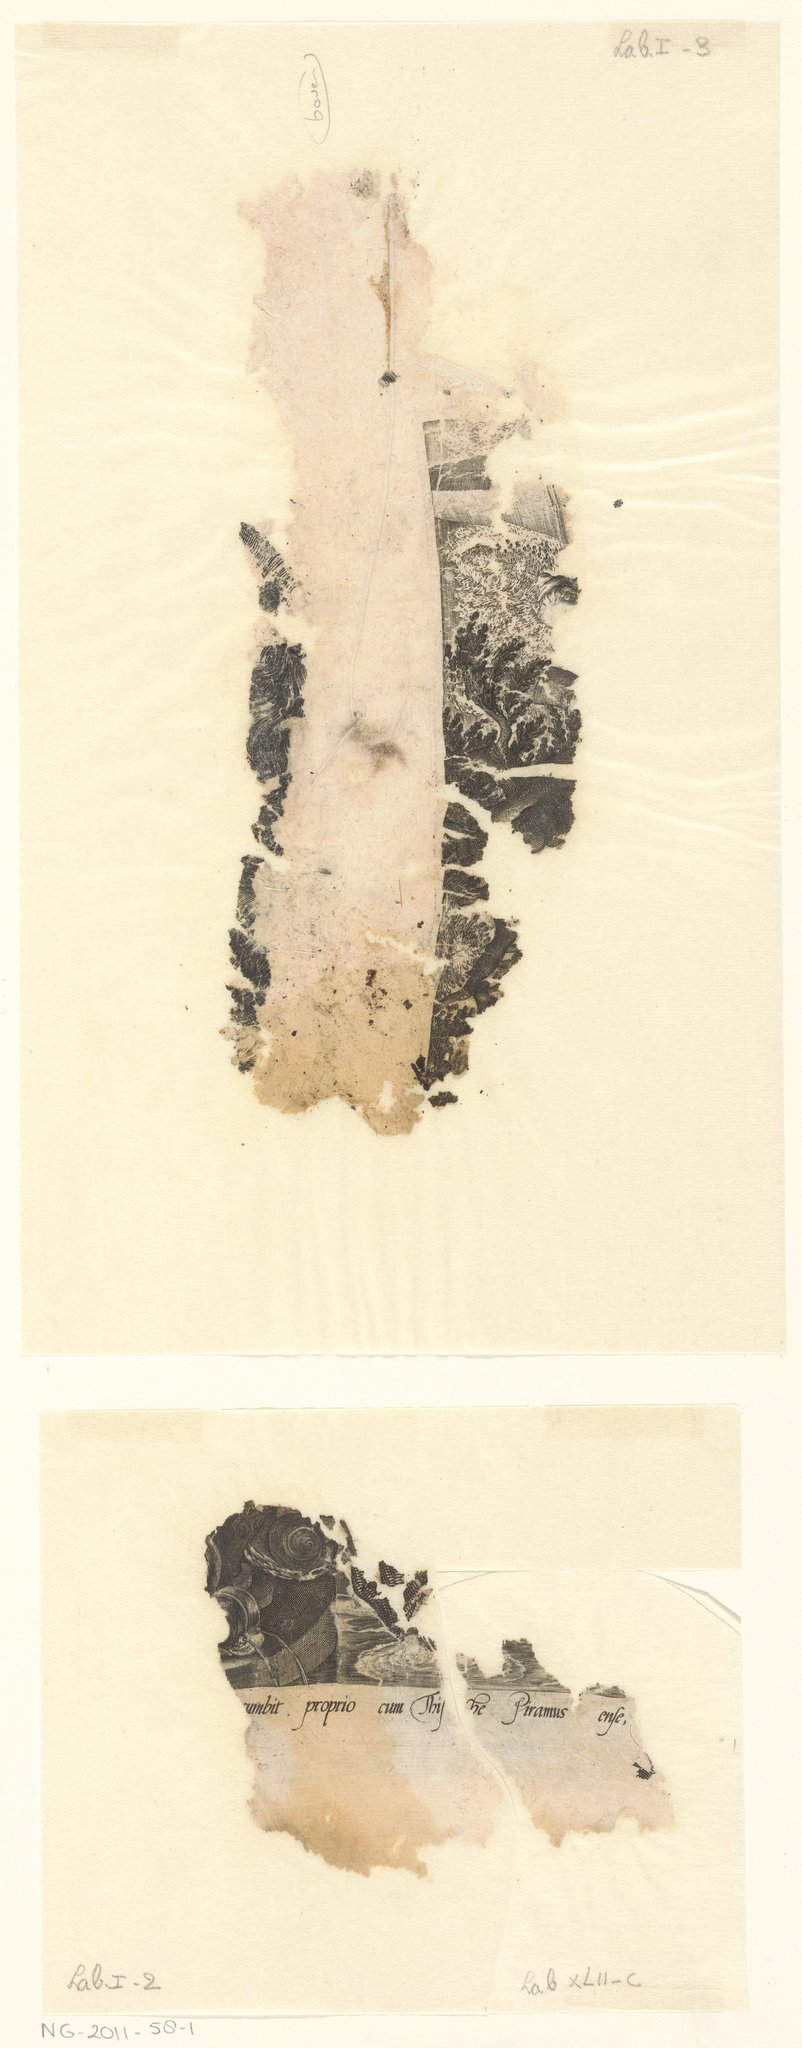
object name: print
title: Losse fragmenten van een prent van Pyramus en Thisbe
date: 1580-1596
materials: paper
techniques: engraving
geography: northern netherlands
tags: thisbe kills herself with pyramus' sword (the scene may be represented near a fountain)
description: De prenten in de Nova Zembla collectie zijn tijdens een expeditie van Willem Barendsz en Jacob van Heemskerk in 1596-1597 noodgedwongen in het winterkamp, het ‘Behouden Huis’, op het eiland achtergelaten. De prenten waren in één of meerdere stapels als handelswaar meegenomen vanuit Amsterdam. Bijna drie eeuwen later, in 1871, keerde de Noor Elling Carlsen terug naar Nova Zembla en vond daar de restanten van het ‘Behouden Huis, inclusief een groot deel van de inventaris. Een deel van de prenten, in de vorm van aaneengekoekte kluiten, werd toen ook teruggevonden. De papierkluiten waren soms op meerdere plekken gebroken. Tussen 1975-1979 zijn de prenten van elkaar gescheiden. Dit leverde in totaal ca. 1000 fragmenten van ca. 400 afdrukken van ca. 150 verschillende prenten op. Voor zover mogelijk zijn de fragmenten samengevoegd en zijn de prenten gereconstrueerd.